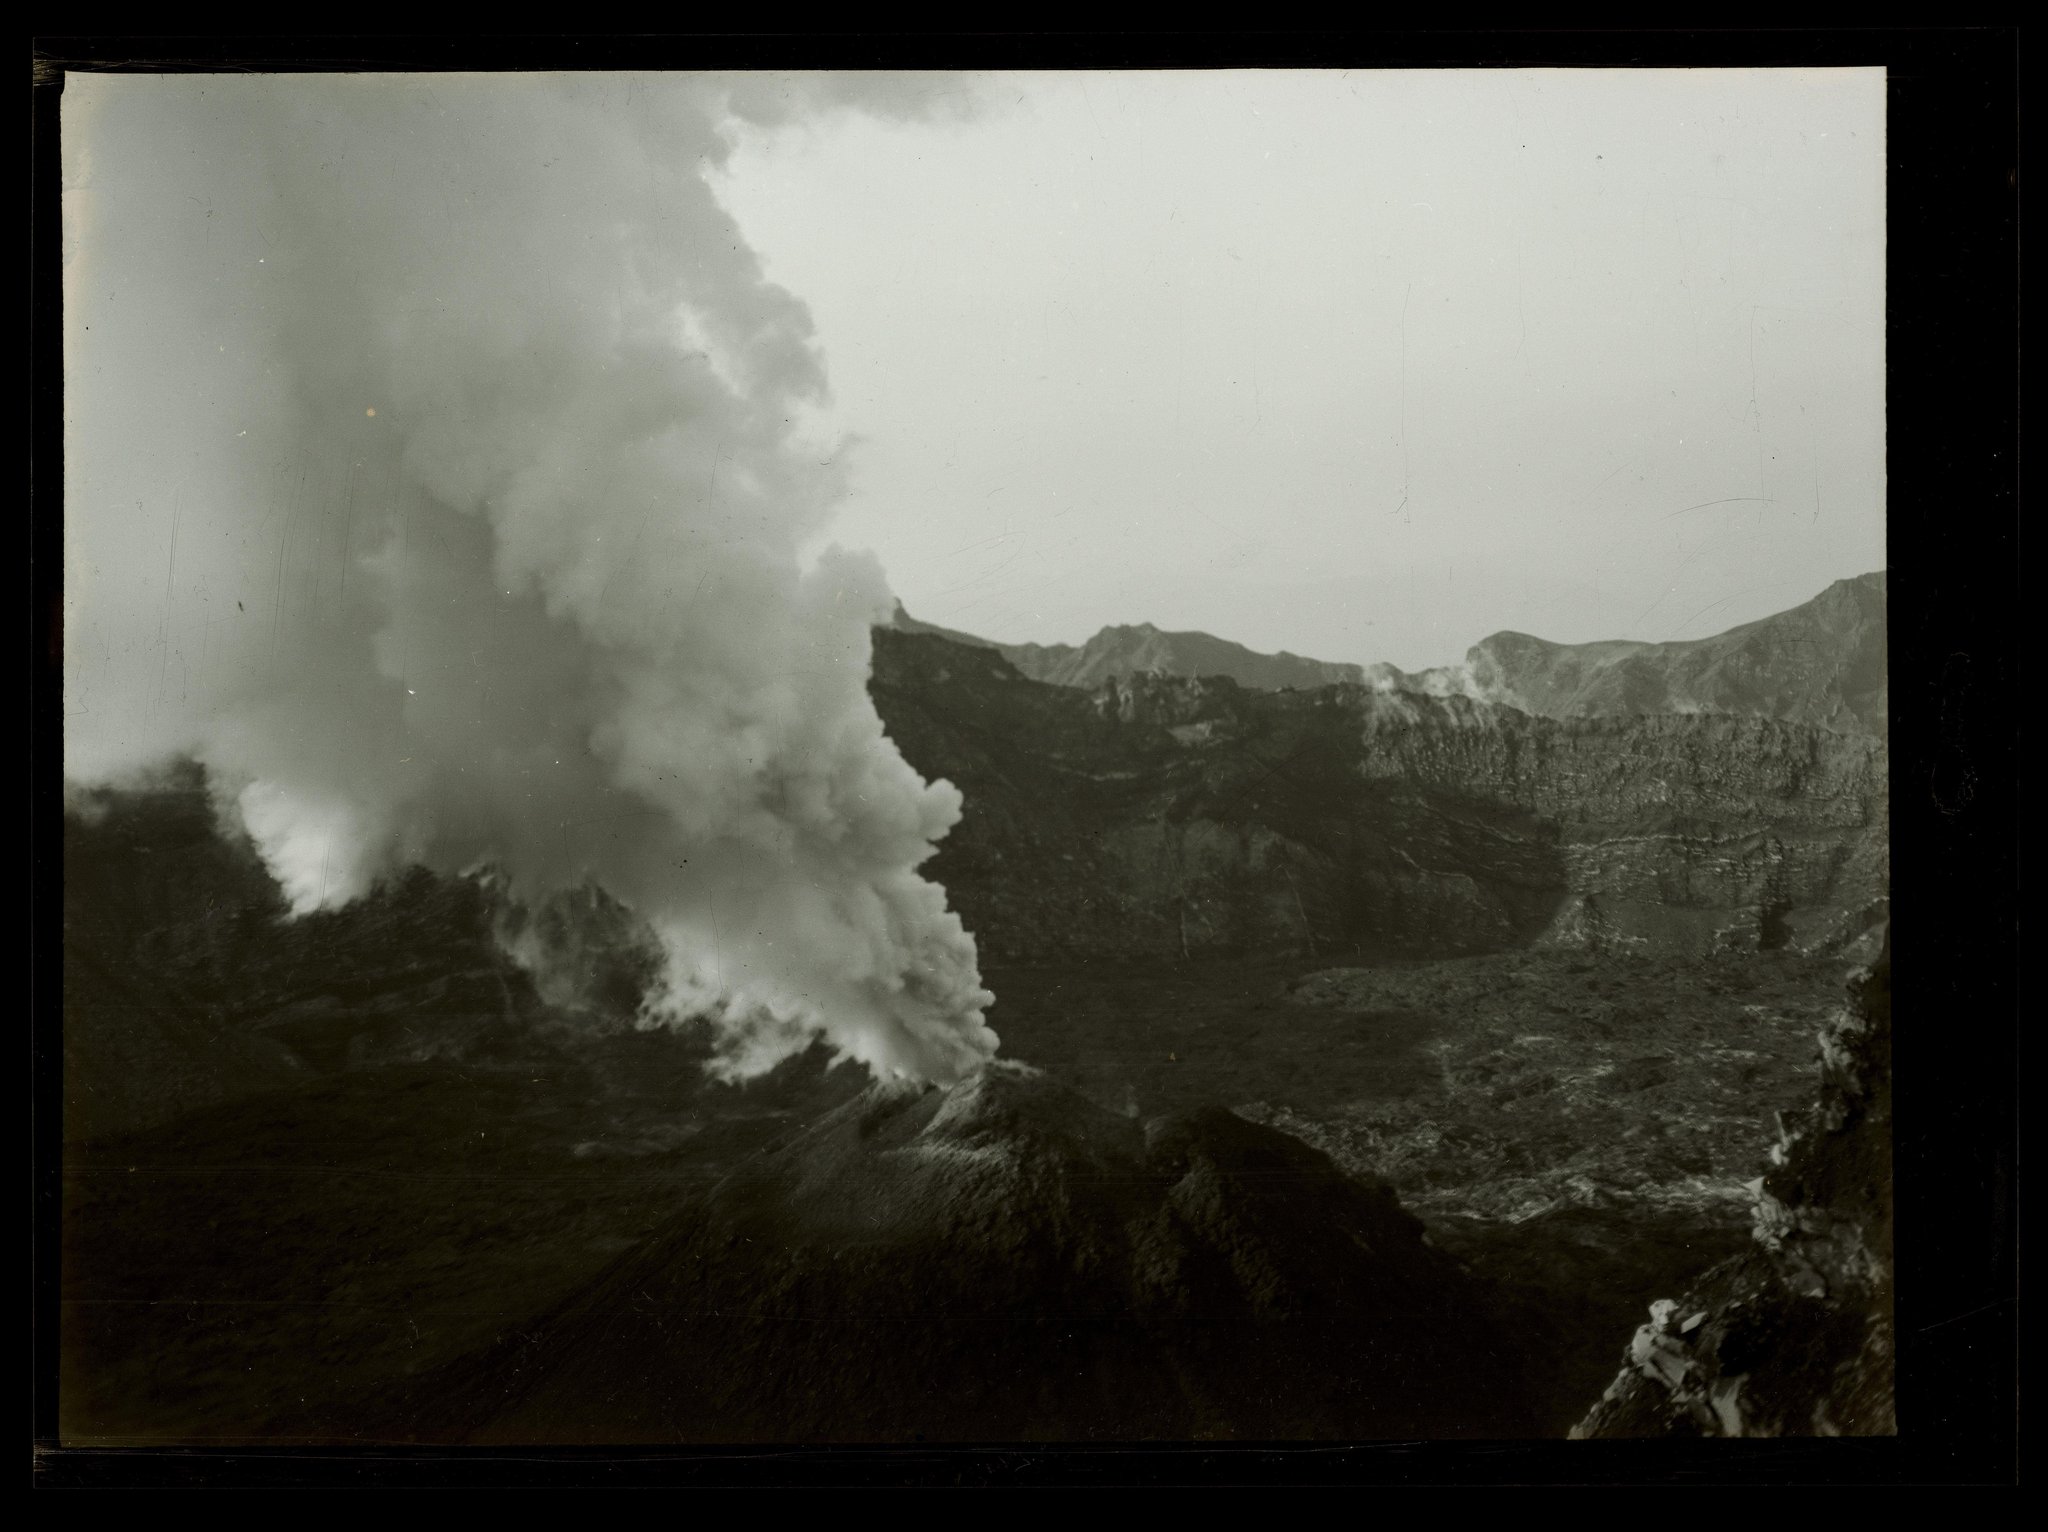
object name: negative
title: Filmnegatief met opname van Napels of omgeving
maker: Anonymous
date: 1907-1935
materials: film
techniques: gelatin silver negative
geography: italy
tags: italy